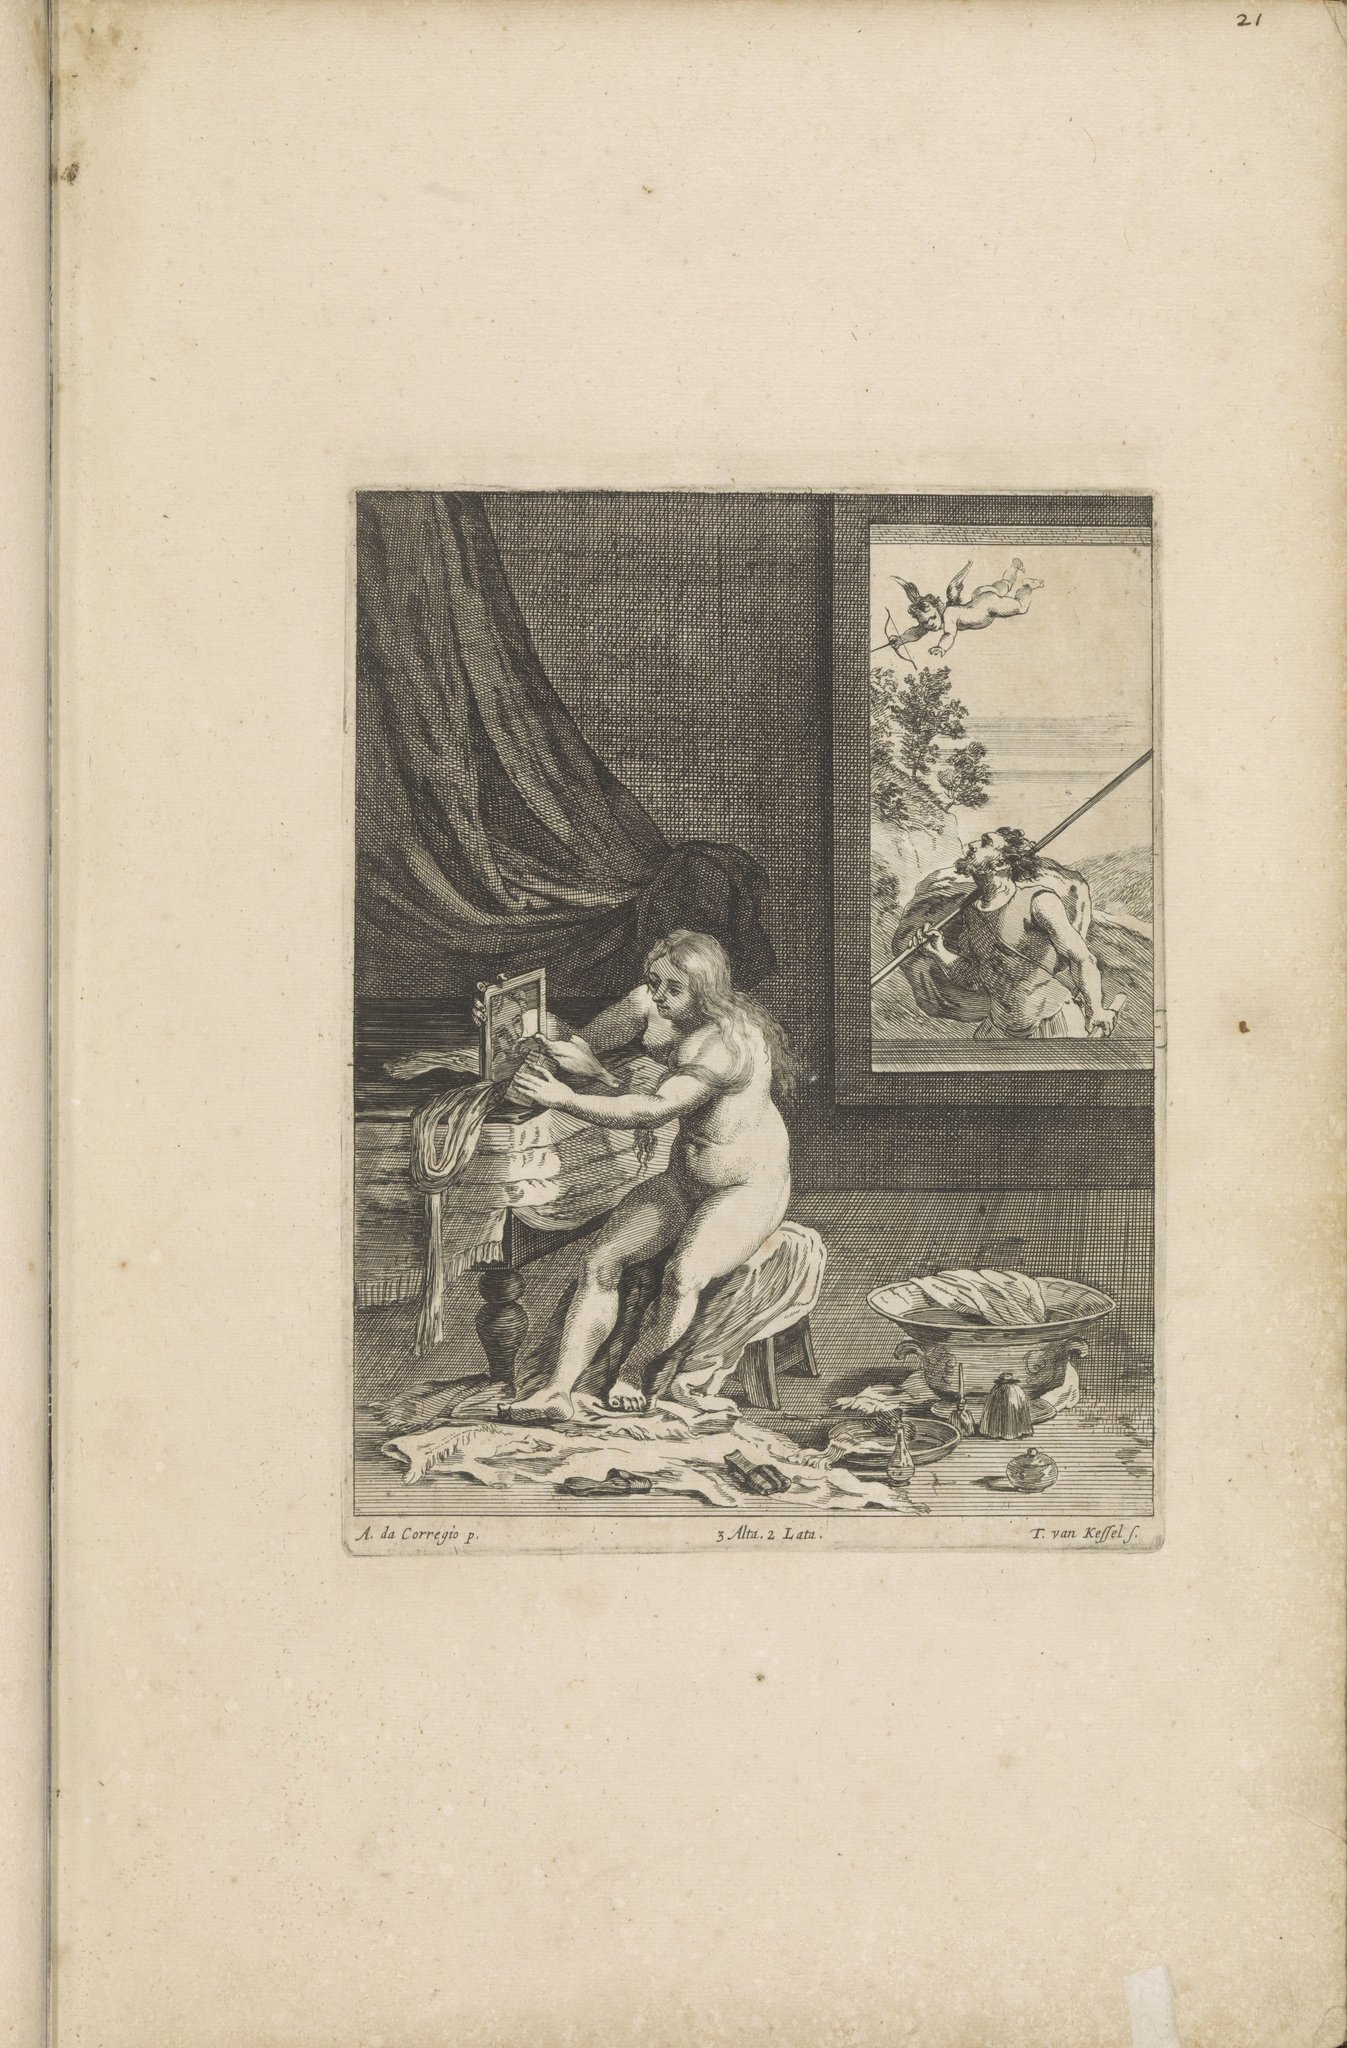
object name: print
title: Venus maakt toilet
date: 1660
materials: paper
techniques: engraving, etching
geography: italy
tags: toilet of venus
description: David Teniers heeft waarschijnlijk van alle schilderijen uit de collectie van Leopold Willem van Oostenrijk een olieverfstudie op doek of paneel vervaardigd (zgn. pasticcio), die als voorbeeld voor de prentmakers diende. Het is niet altijd duidelijk of de pasticci door hem zijn gemaakt of door zijn atelier. Niet alle pasticci zijn overgeleverd.